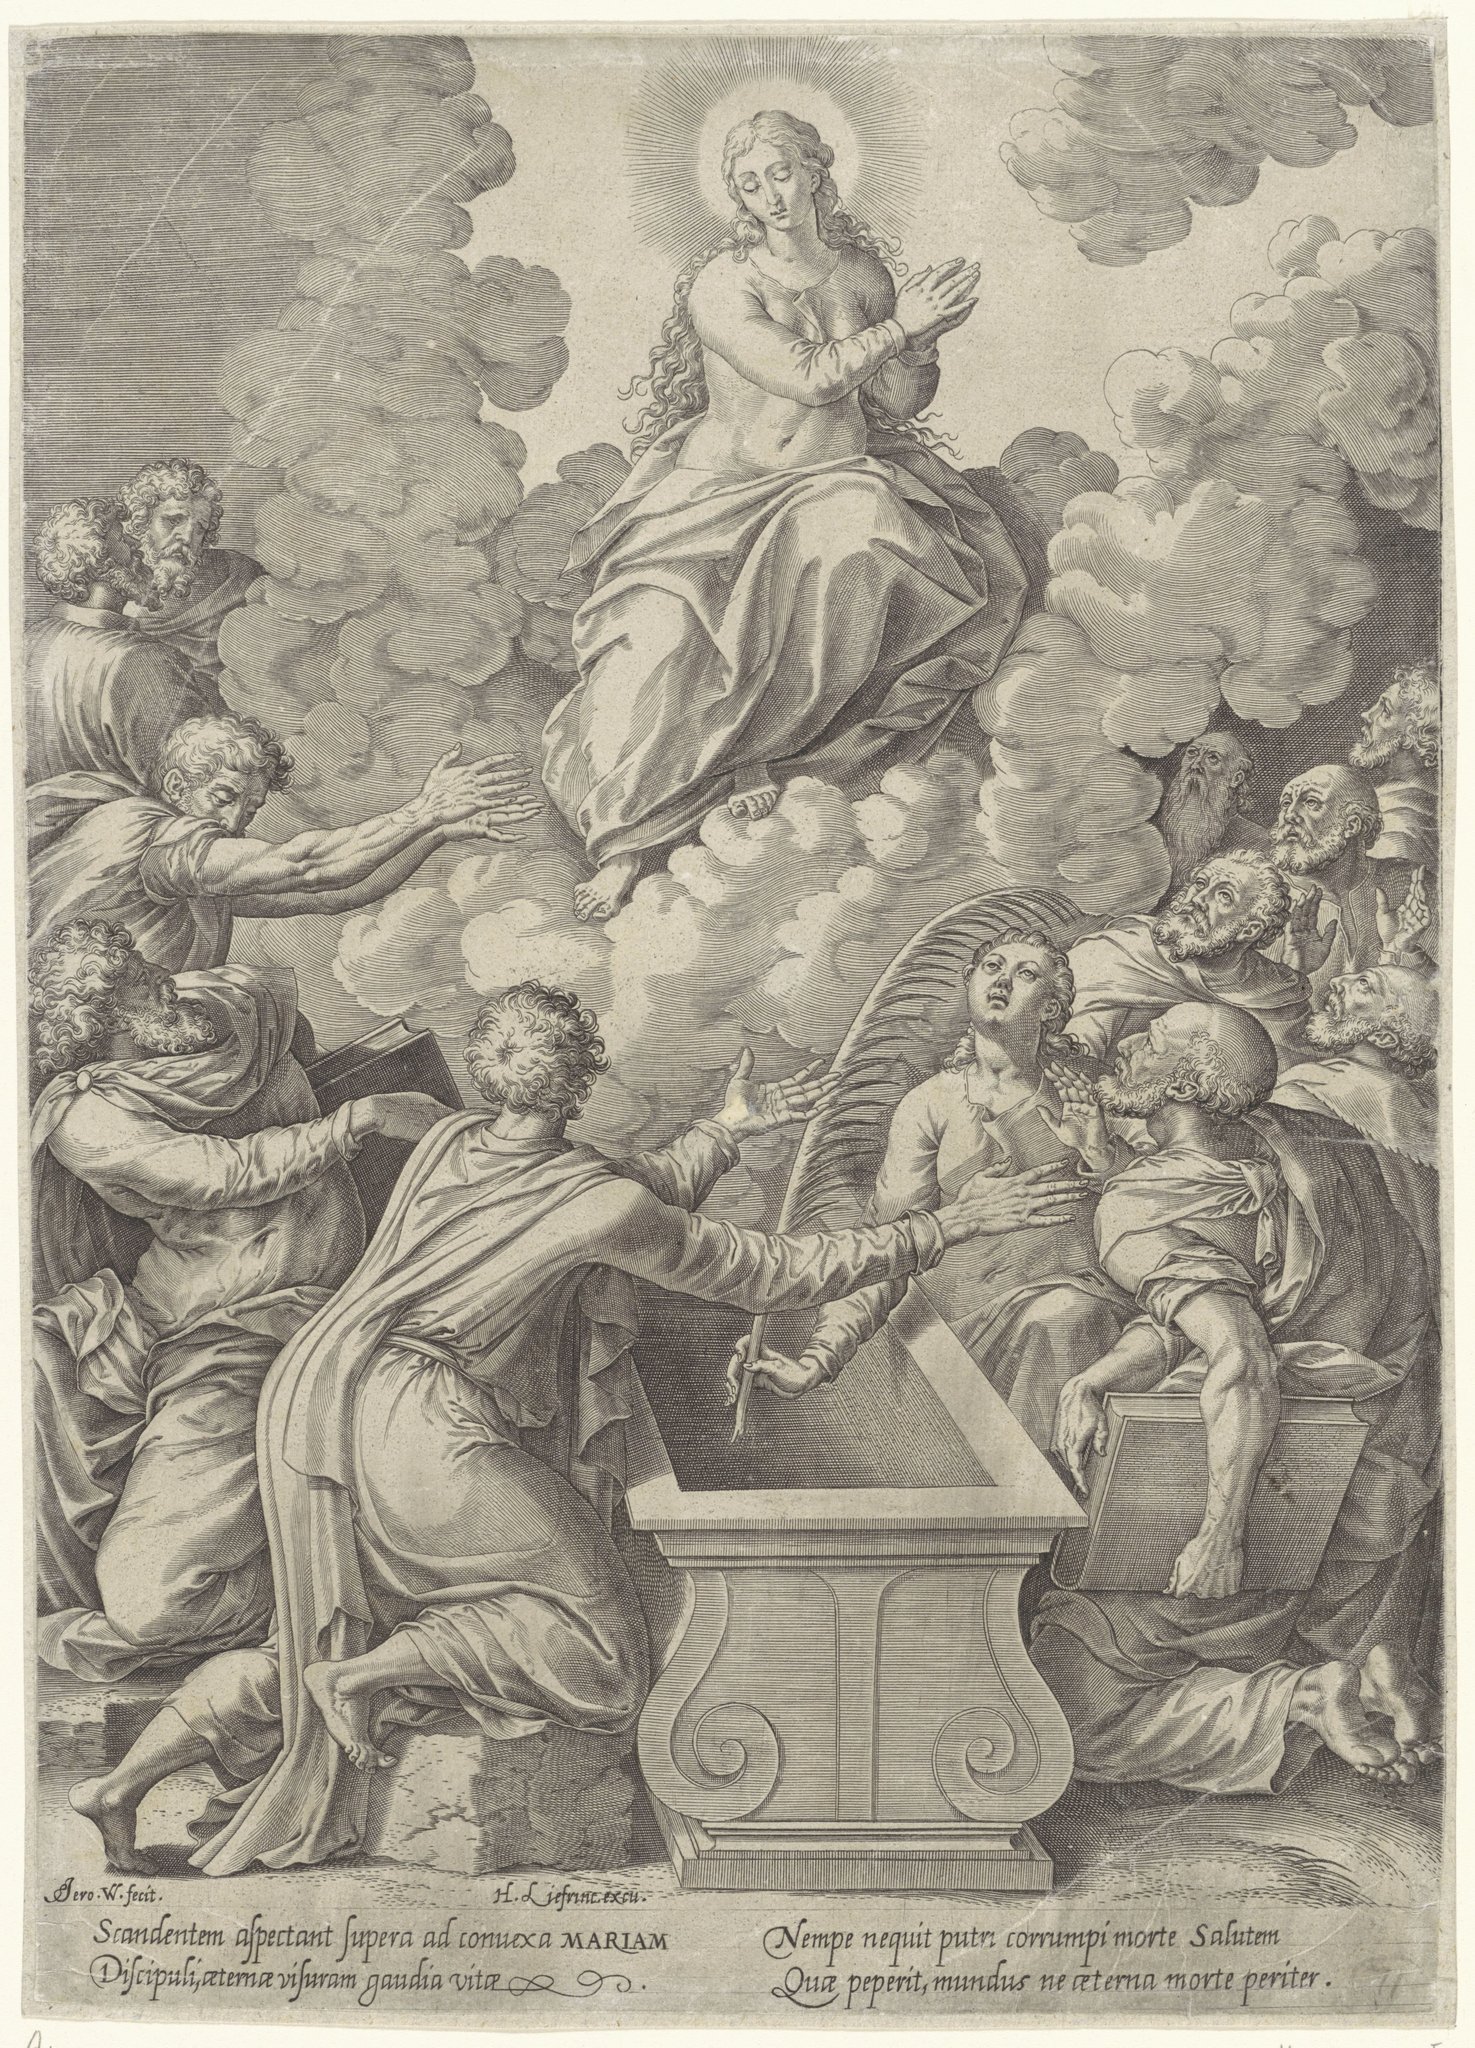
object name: print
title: Hemelvaart van Maria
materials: paper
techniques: engraving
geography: antwerp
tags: the assumption of mary ('assumptio corporis'): she is borne into heaven by angels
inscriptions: number: ‘M.30./8/52.747.19[?]’, collector's mark: Lugt 2228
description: Maria wordt op de wolken meegevoerd naar de hemel. Rondom haar open graf de verzamelde apostelen die voor haar ziel bidden. In de marge een vierregelig onderschrift, in twee kolommen, in het Latijn.